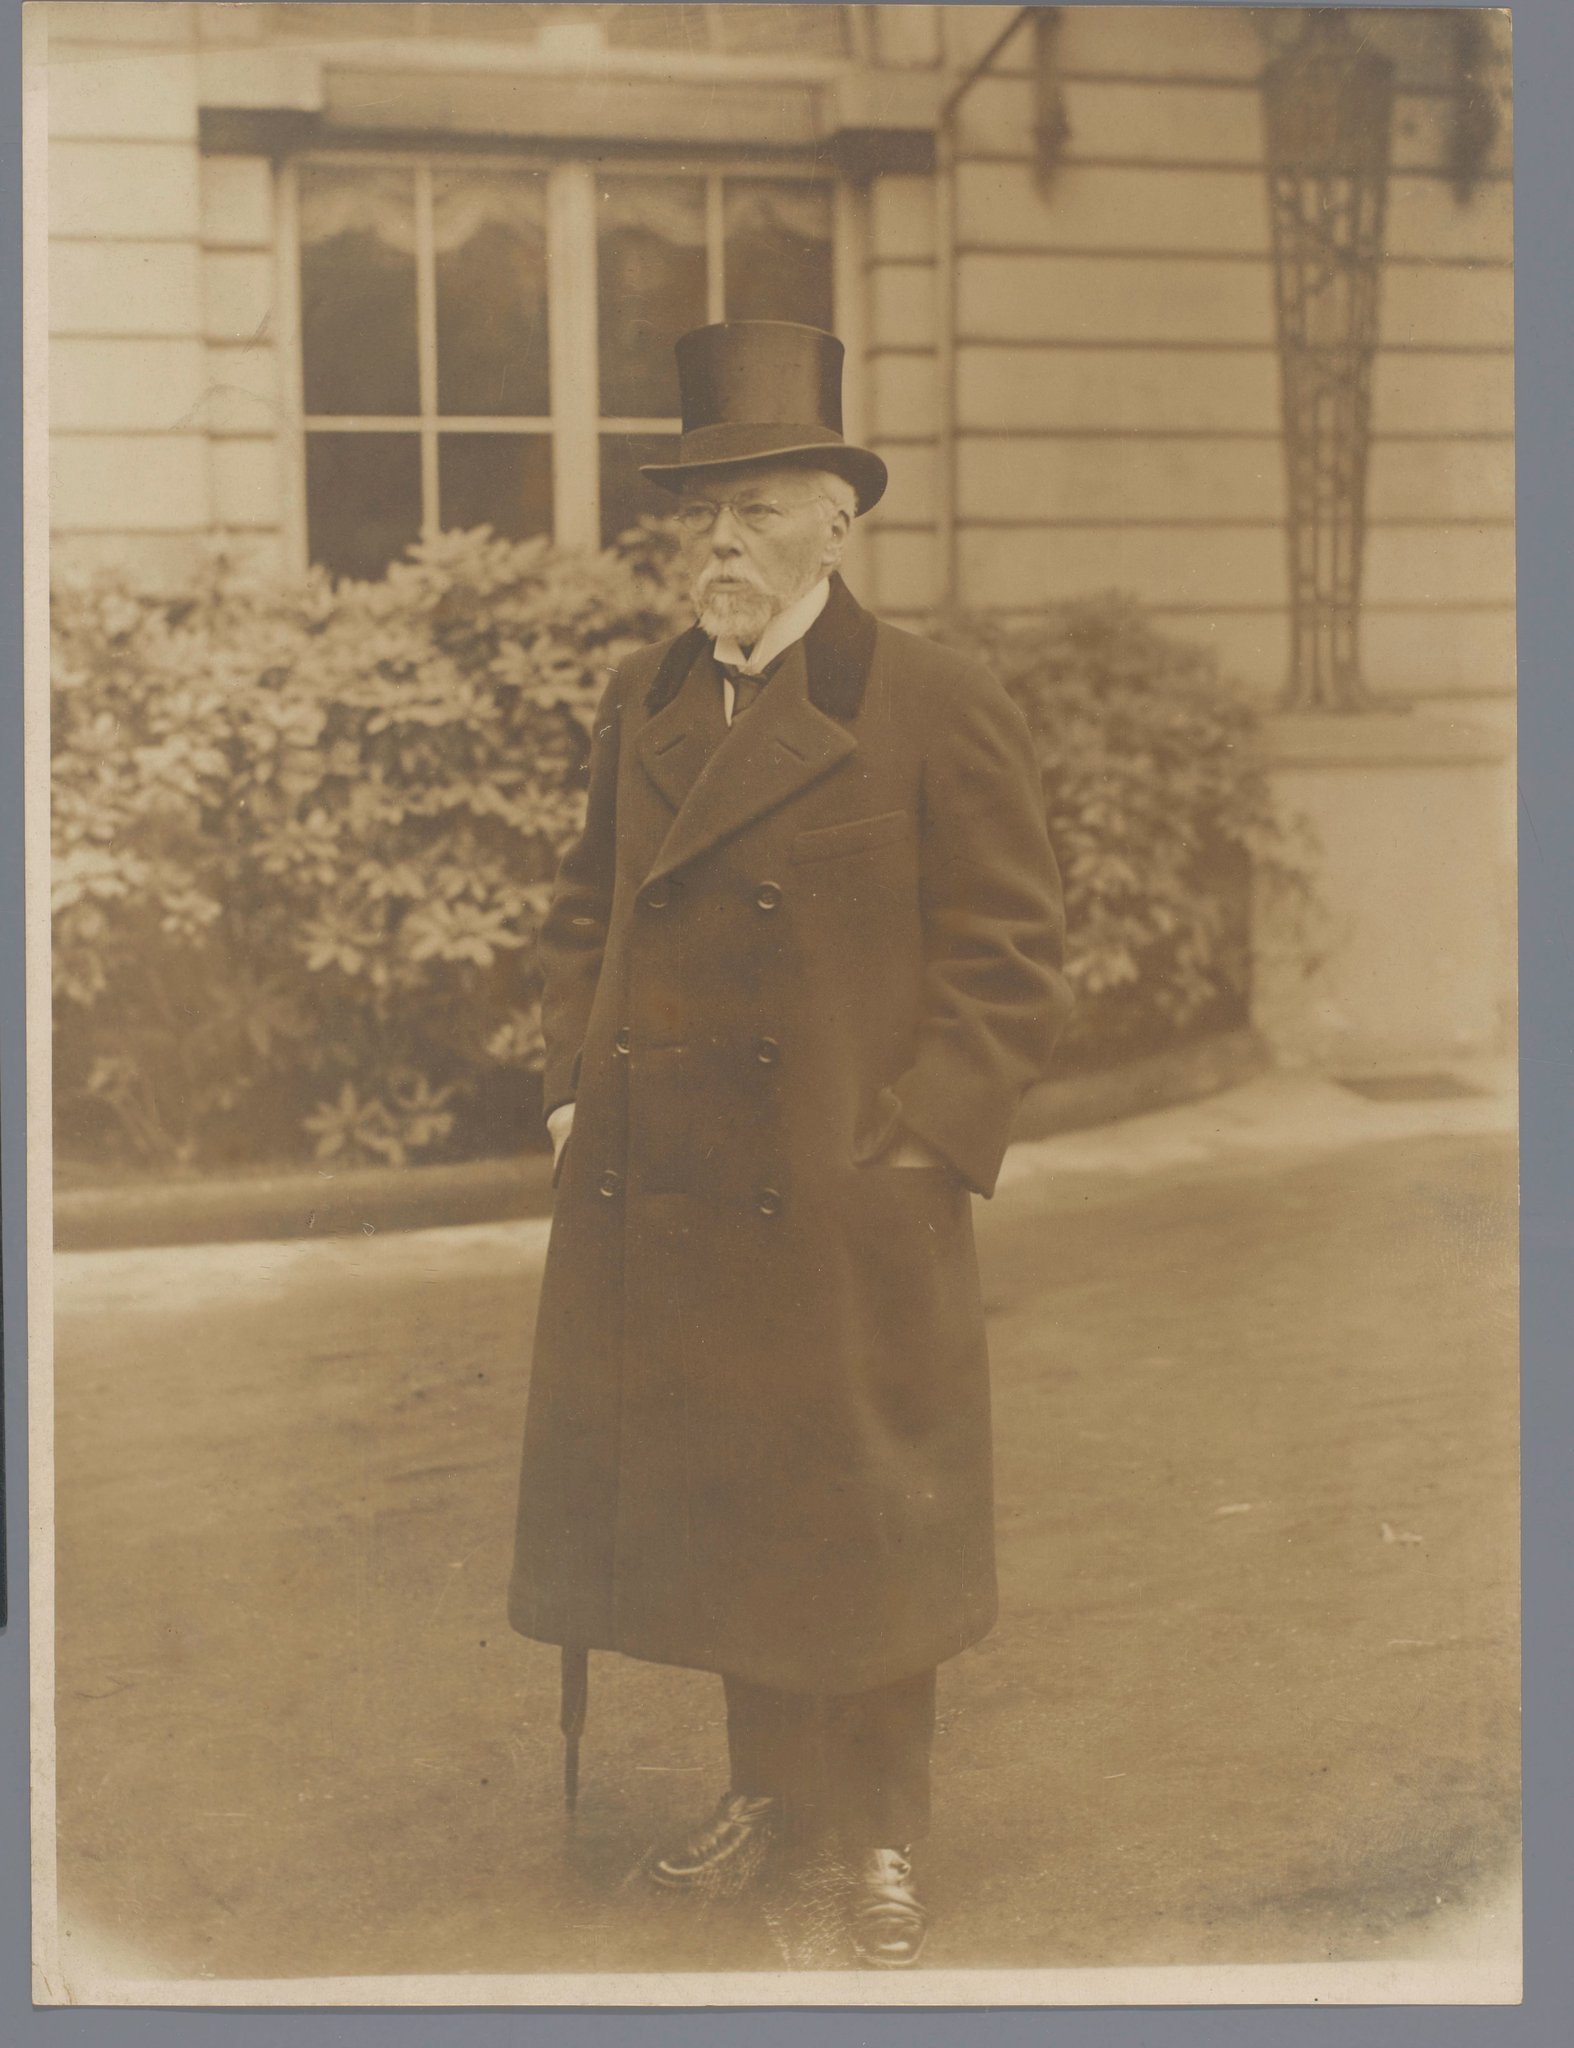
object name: photograph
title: Portret van een onbekende man, waarschijnlijk een politicus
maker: Anonymous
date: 1914-1918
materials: paper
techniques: gelatin silver print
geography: germany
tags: historical persons, old man, germany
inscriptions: number: ‘No 505.’